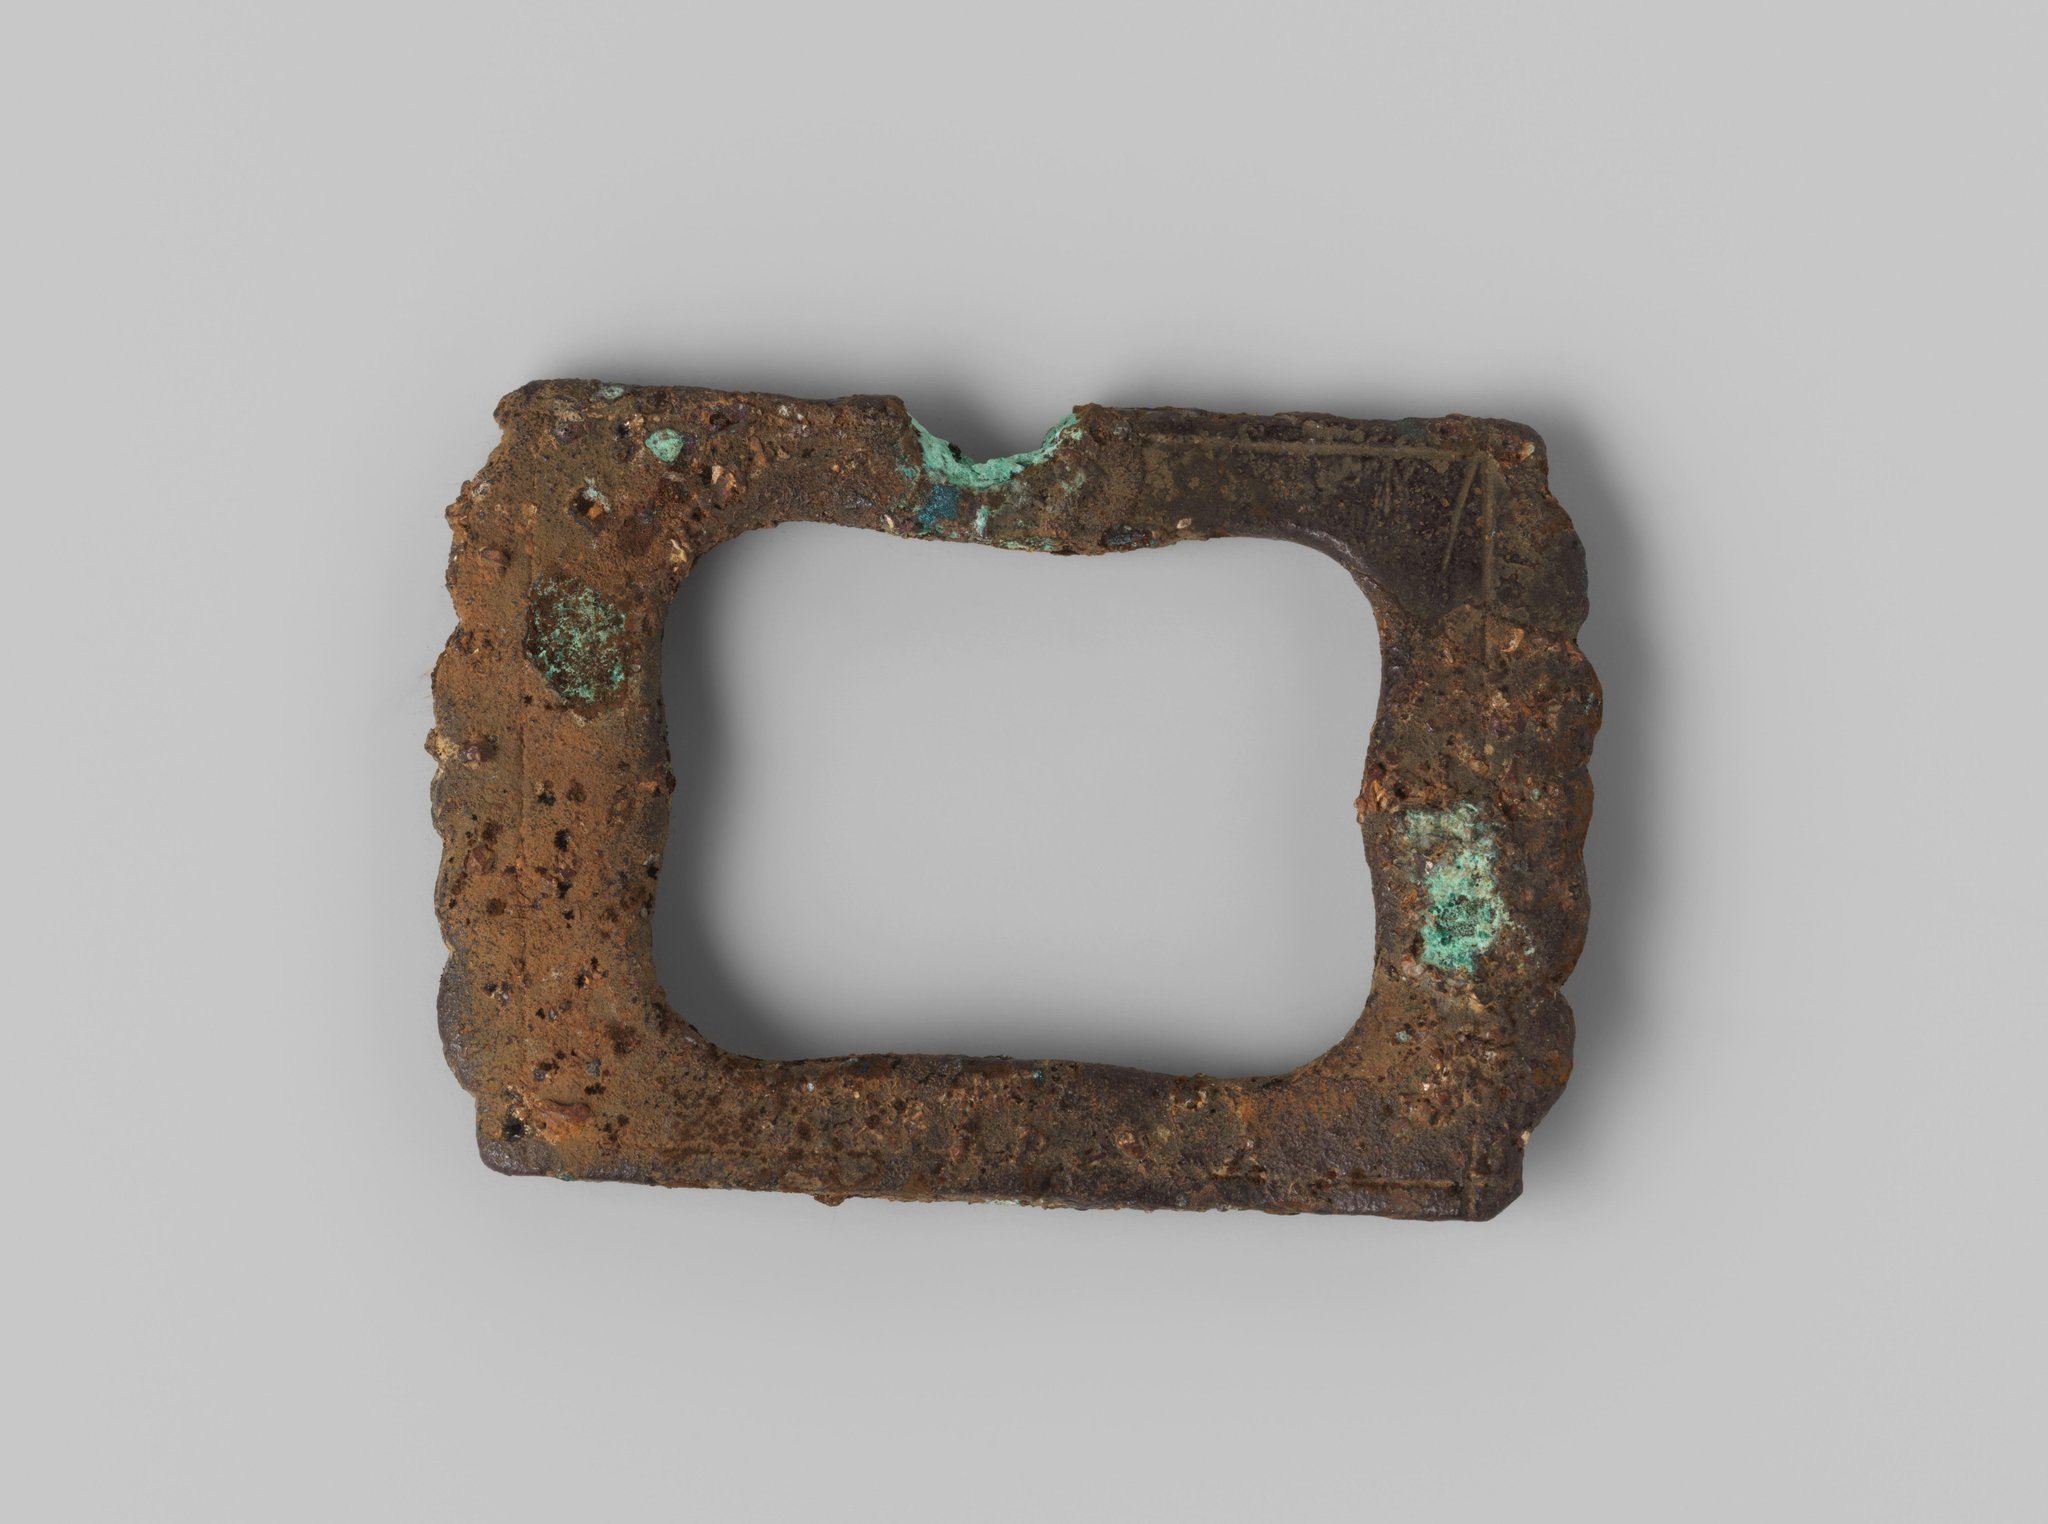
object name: buckle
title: Gesp uit het wrak van de Oost-Indiëvaarder Hollandia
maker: Anonymous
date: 1700-1743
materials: copper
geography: netherlands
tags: verenigde oostindische compagnie, hollandia (schip), annet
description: Buckle, not identifiable; ring, rectangular, curving short sides with wavy outer rim, flat.